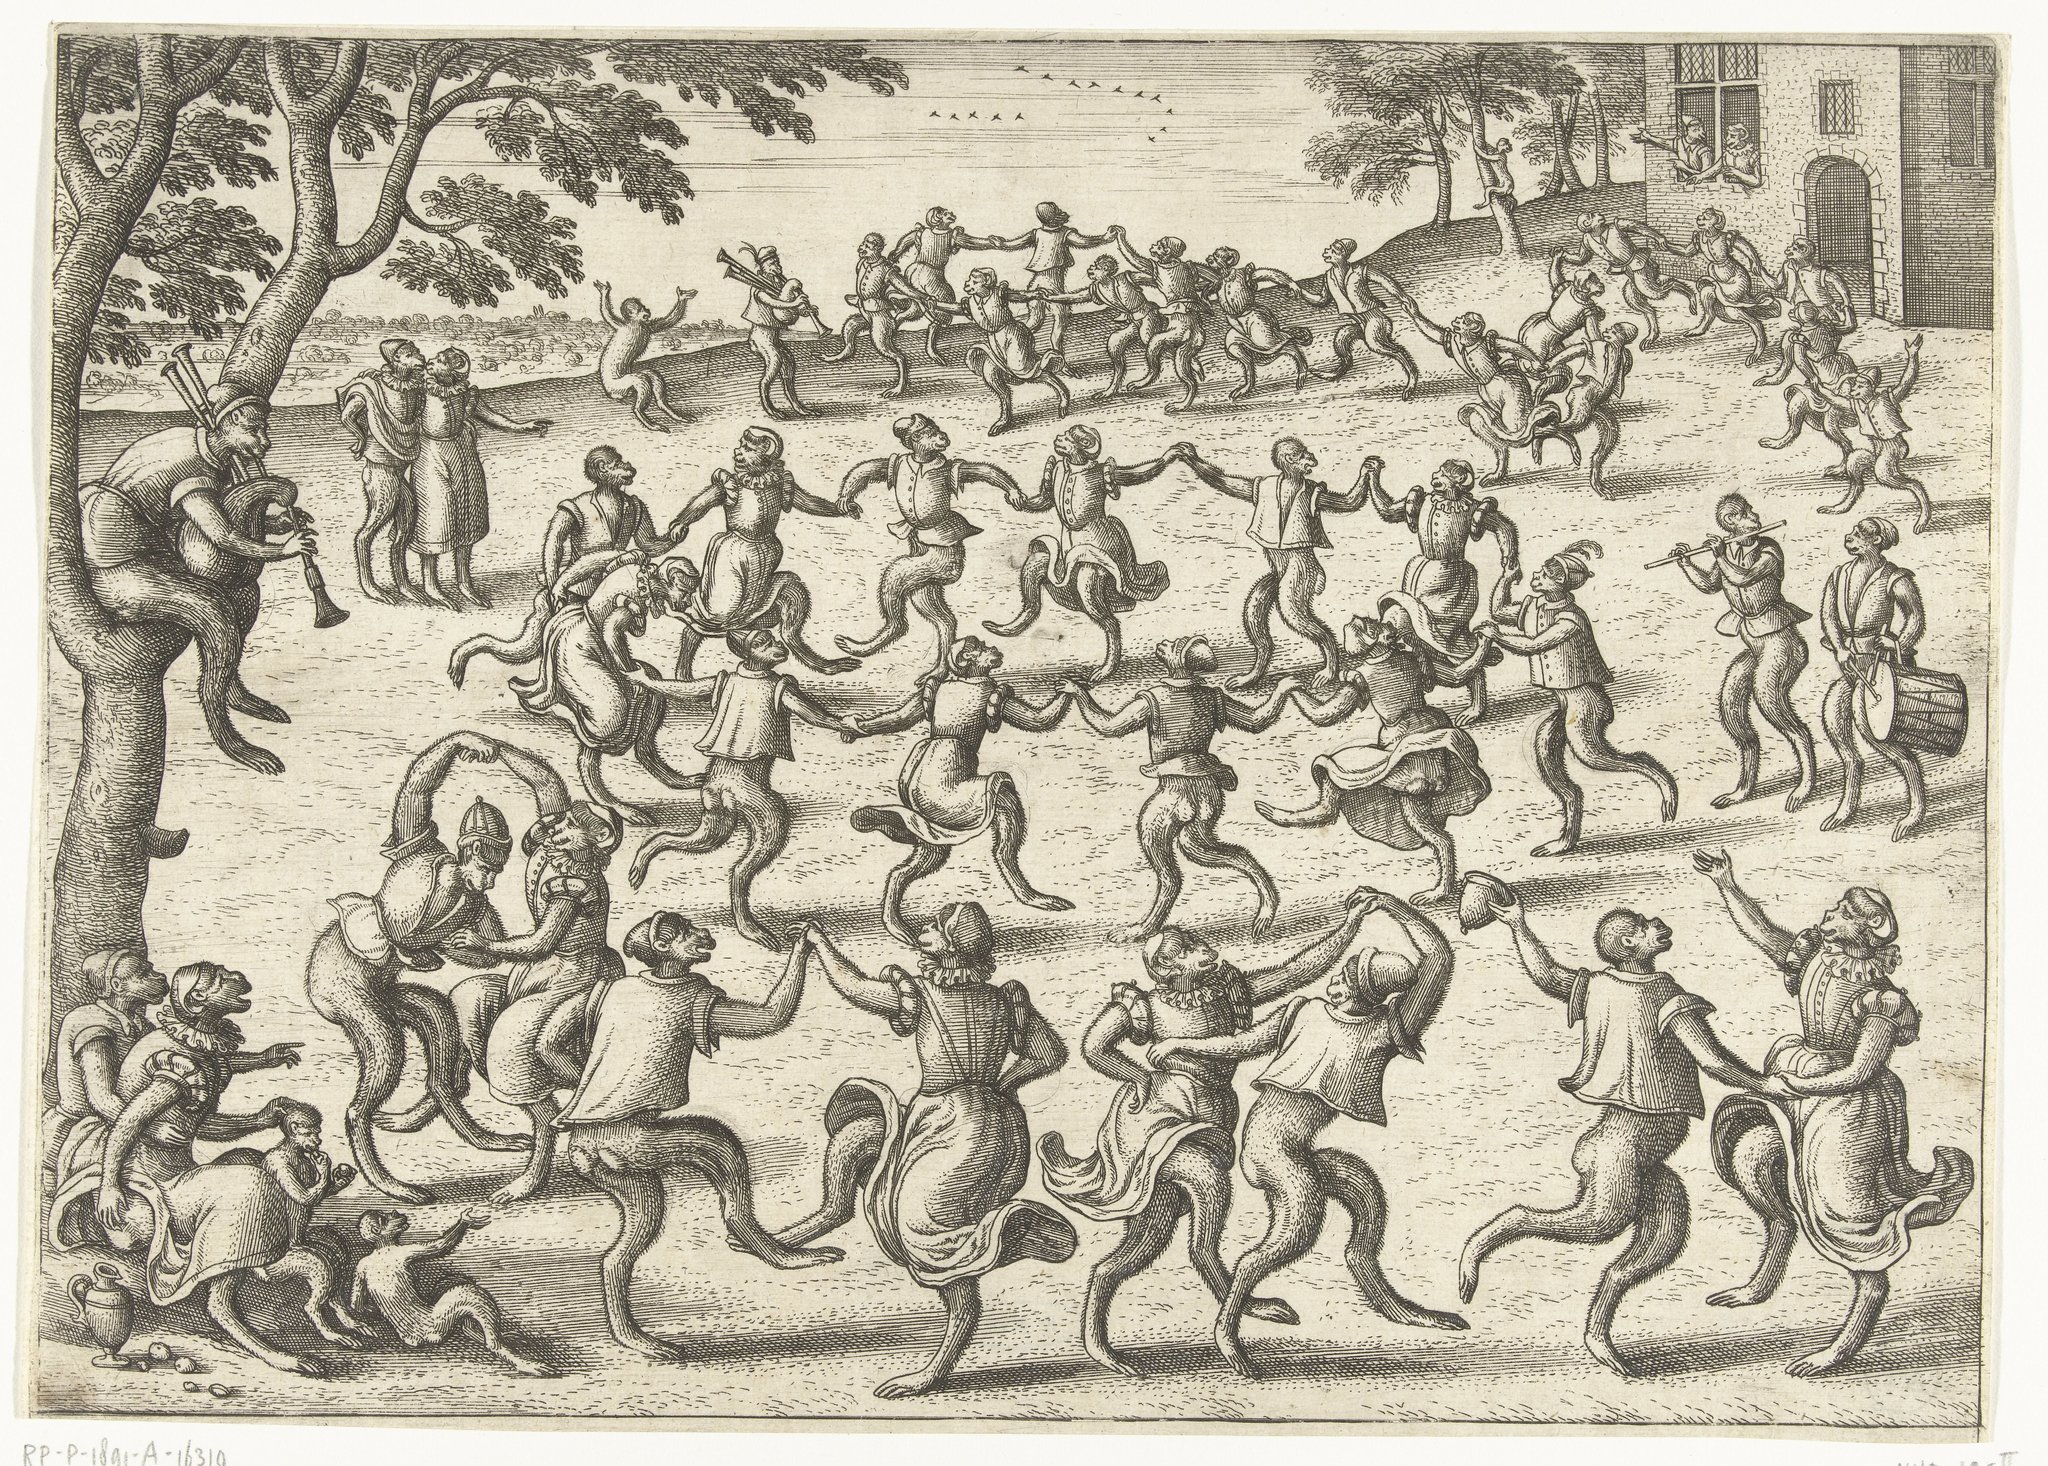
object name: print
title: Rondedans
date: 1545-1608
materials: paper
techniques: etching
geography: antwerp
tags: monkeys, apes, 'mundus inversus', the reversed world, the topsy-turvy world, 'le monde bestourné', skates (winter sports)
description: Verschillende dansen uitgevoerd door apen, begeleid door een trommelaar, een fluitist en twee doedelzakspelers (een in een boom en een op de grond). Toeschouwers kijken vol bewondering toe.